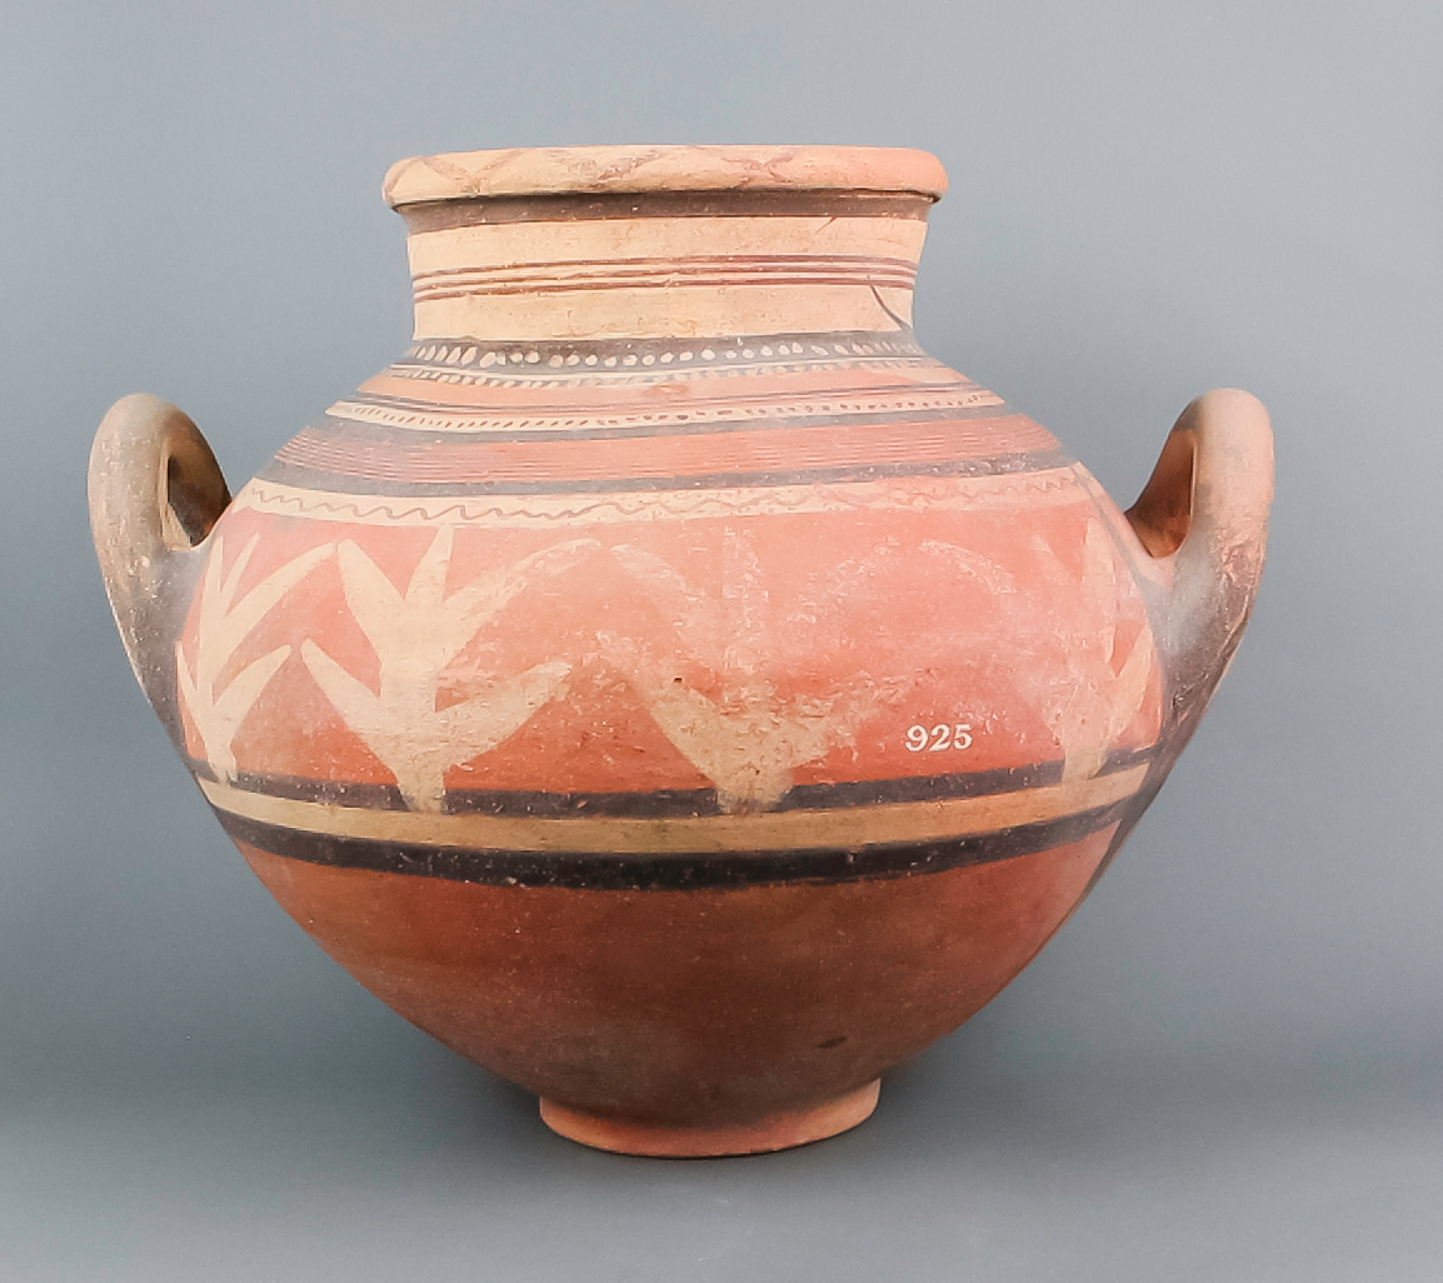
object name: amphora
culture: cypriot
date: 750-600 BCE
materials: terracotta